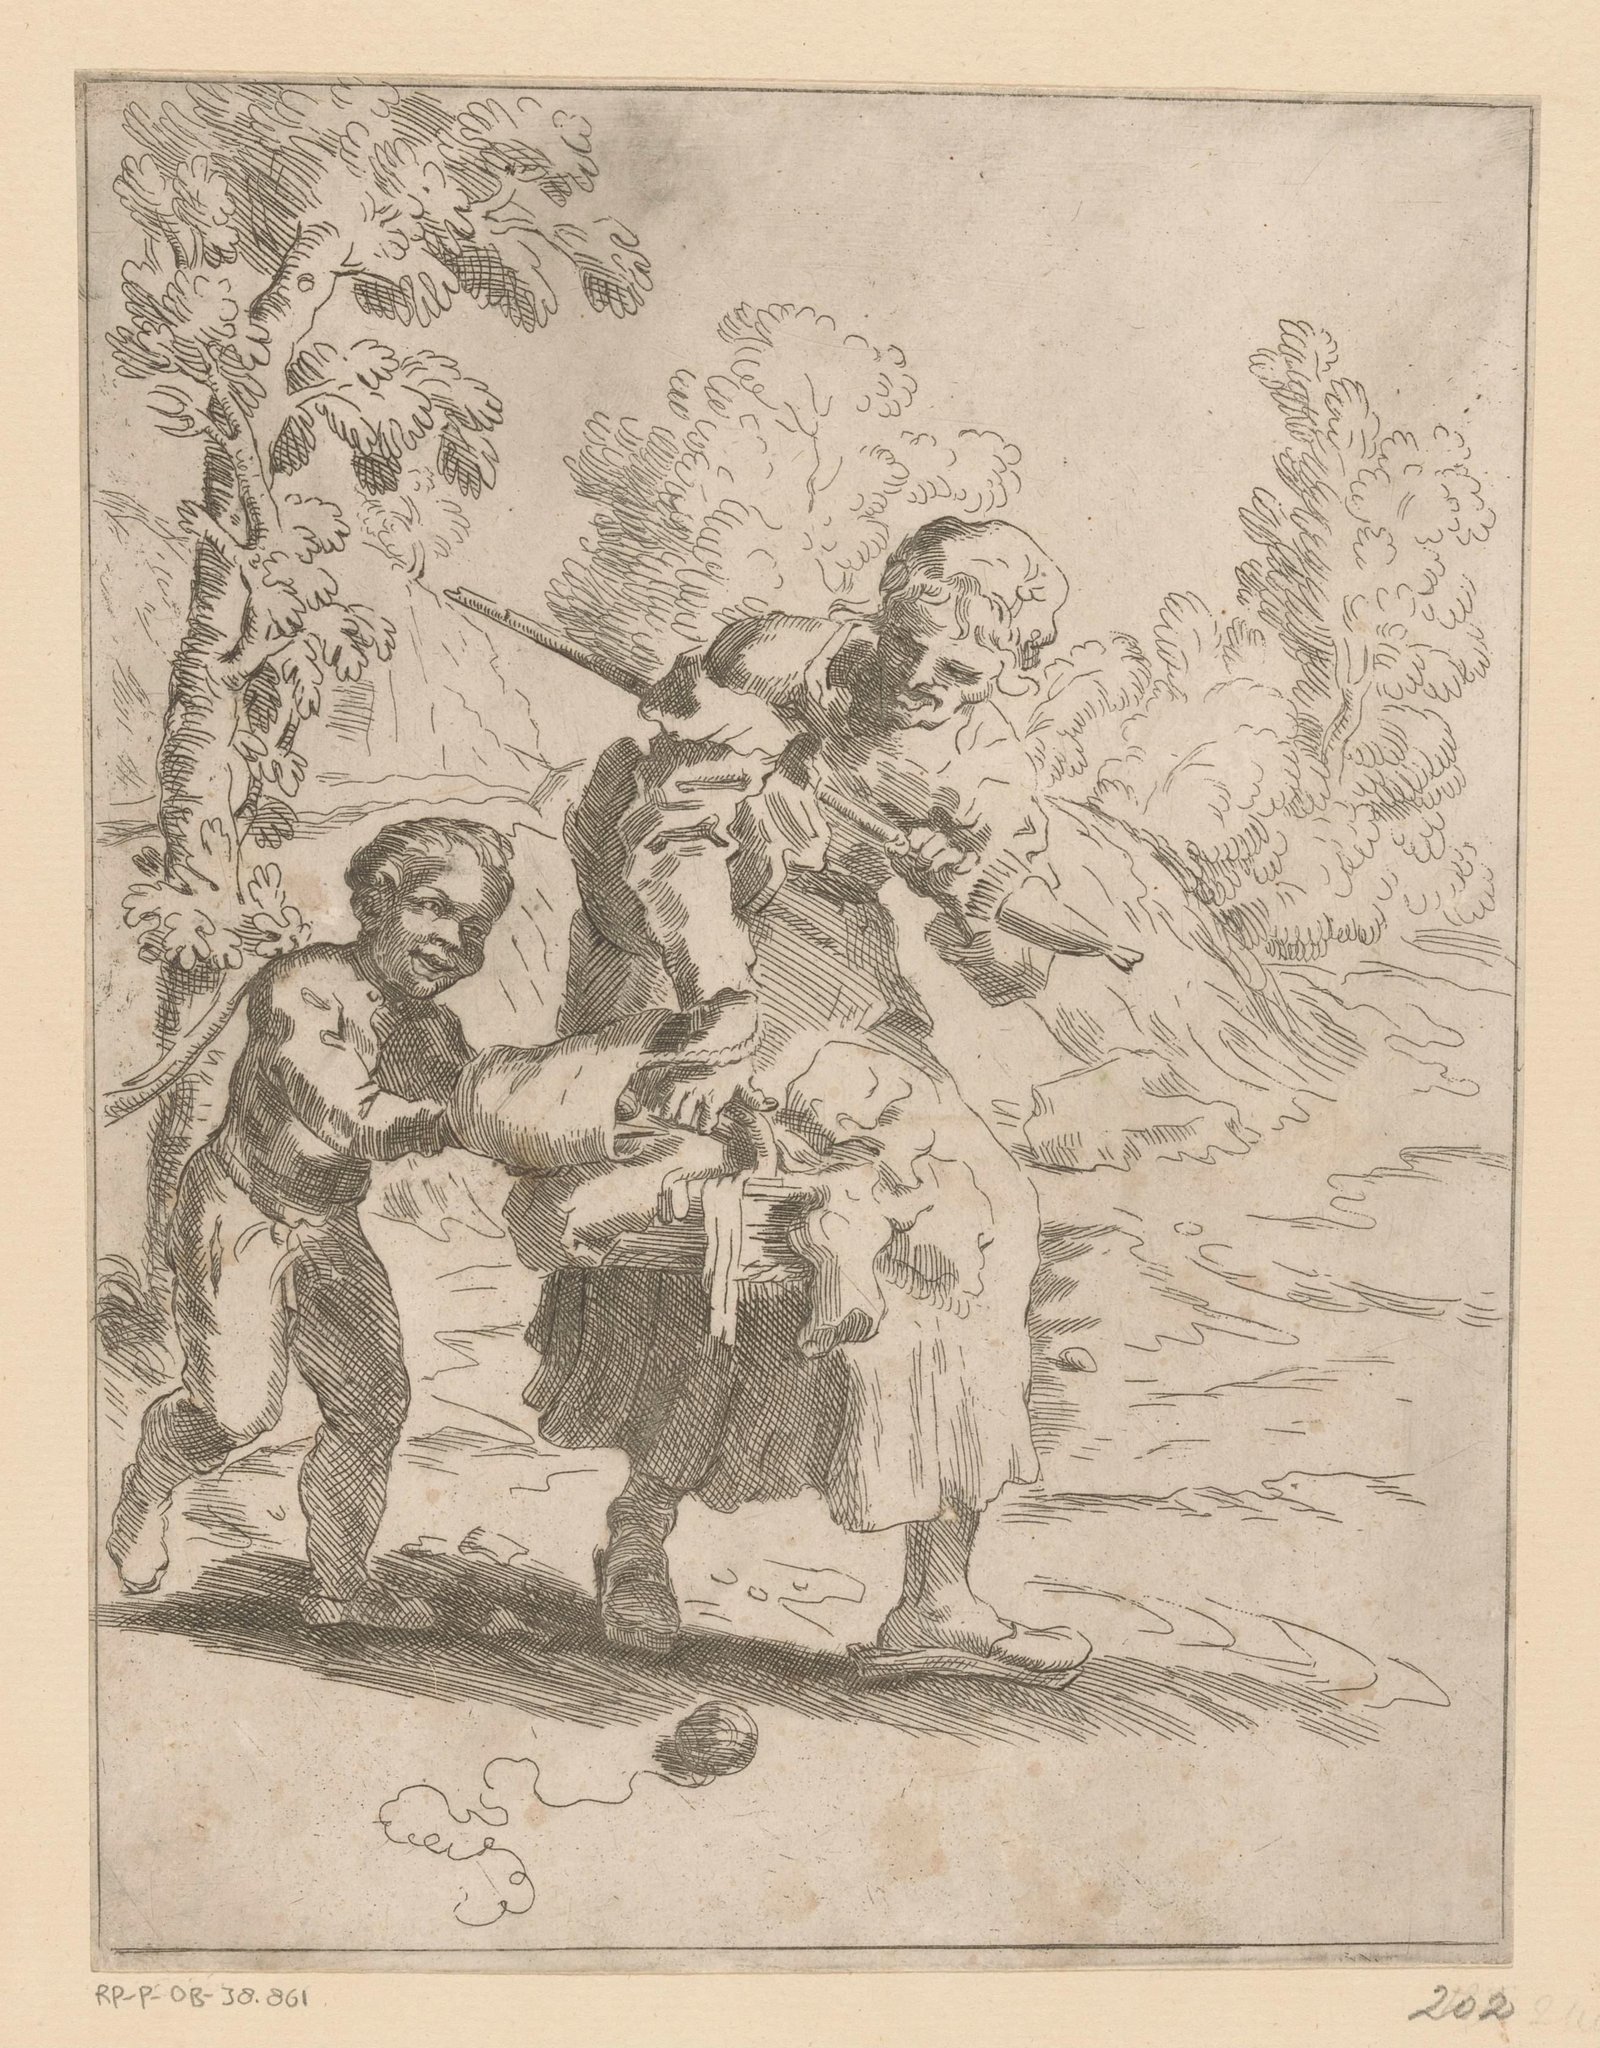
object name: print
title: Oude vrouw met een jongen op pad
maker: Anonymous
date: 1650-1749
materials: paper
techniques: etching, intaglio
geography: italy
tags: landscapes, distaff, walking, wool (material ~ textile industry)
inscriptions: collector's mark: Lugt 240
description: Oude vrouw, met een spinrok en twee gevulde manden, loopt samen met een jongen door een landschap. Op de voorgrond ligt een bol van wol.